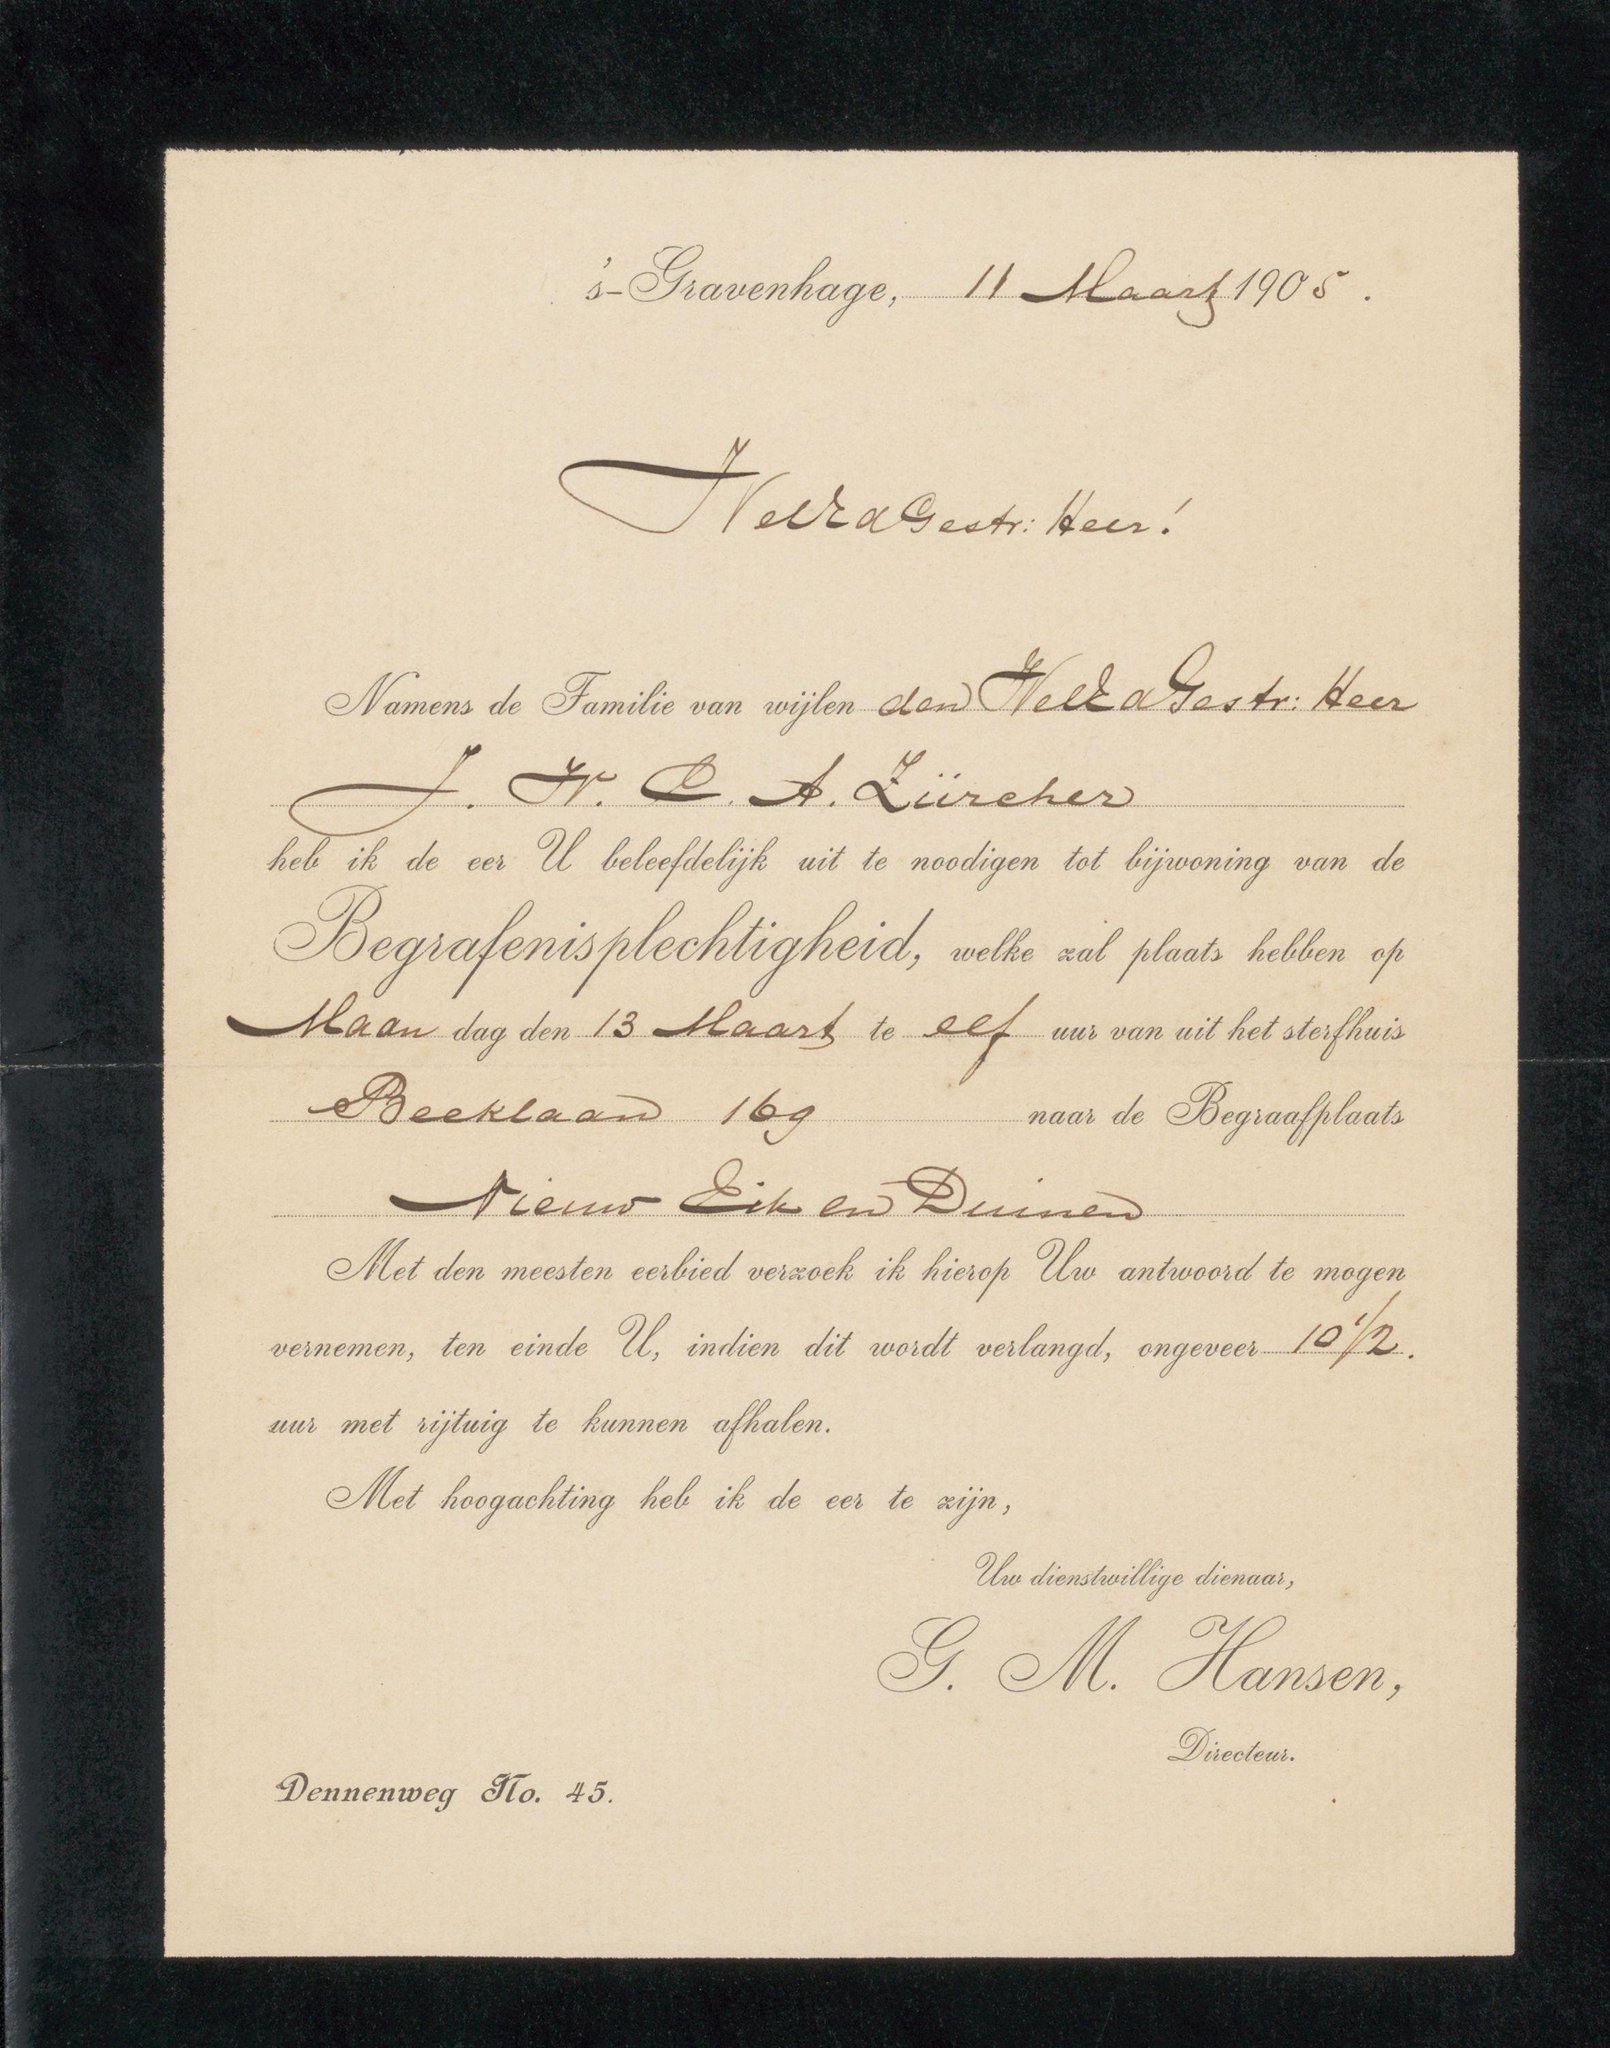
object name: invitation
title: Uitnodiging aan Philip Zilcken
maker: g.m. hansen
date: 1905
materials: ink, paper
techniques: pen, printing, writing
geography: the hague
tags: jan zürcher, draughtsman, philip zilcken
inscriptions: collector's mark: ‘RPK’